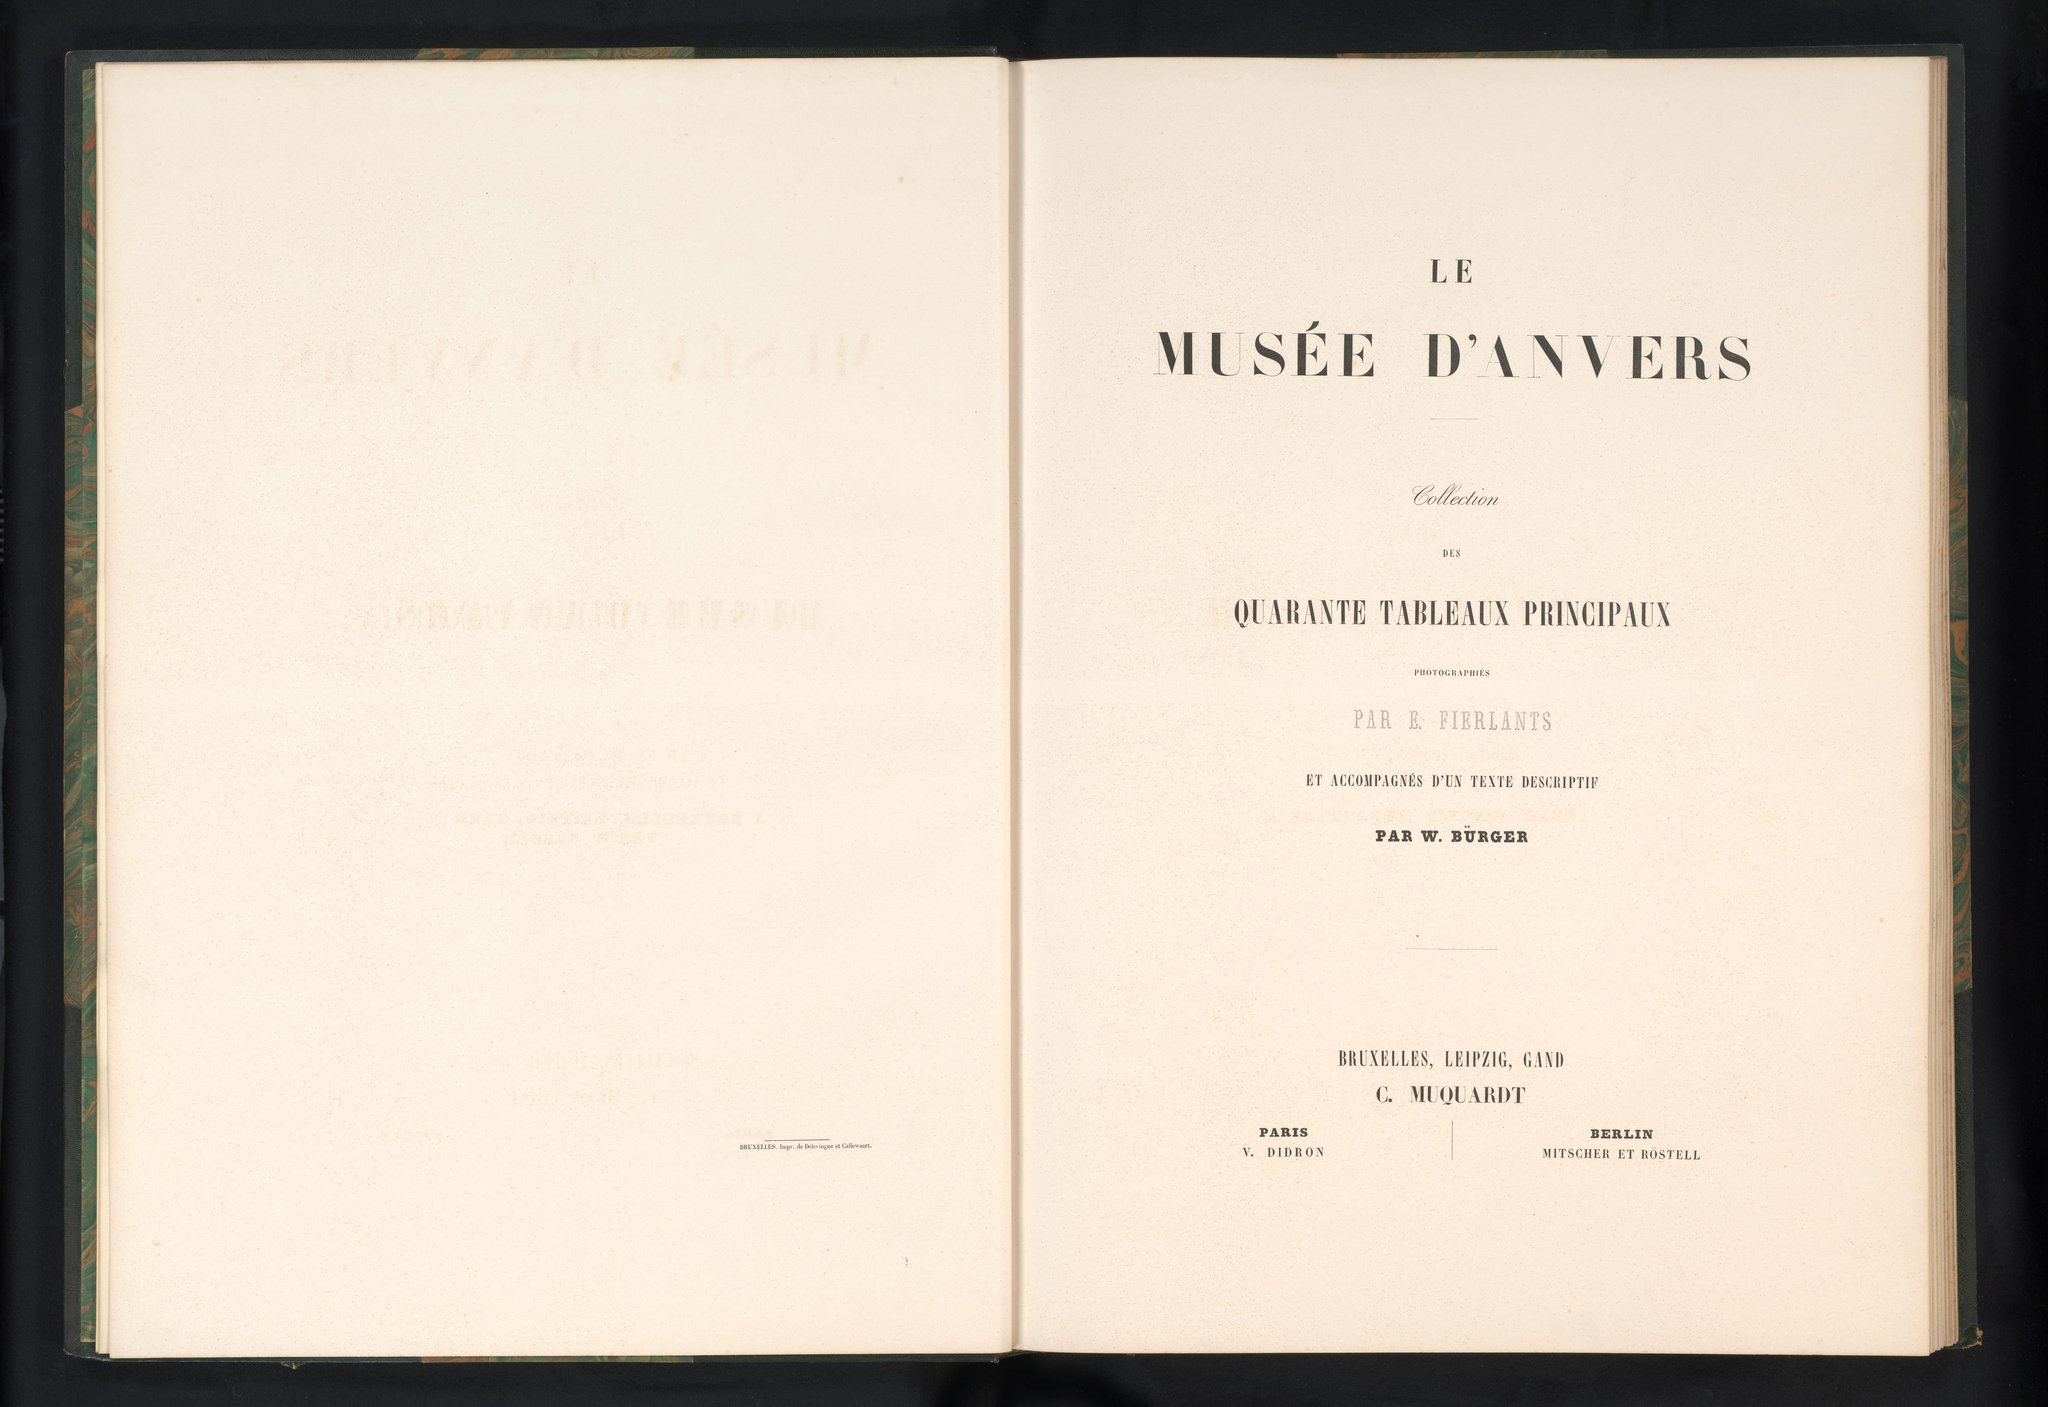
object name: book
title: Le Musée d'Anvers : collection de quarante tableaux principaux / photographiés par E. Fierlants ; d'accompagnés d'un texte descriptif par W. Bürger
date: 1861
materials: cardboard, leather, linen, paper, photographic support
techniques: albumen print, marbling, printing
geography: brussels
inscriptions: annotation: ‘Coll. Joseph’, number: ‘A.W./ No 13918/ OCT 1998’